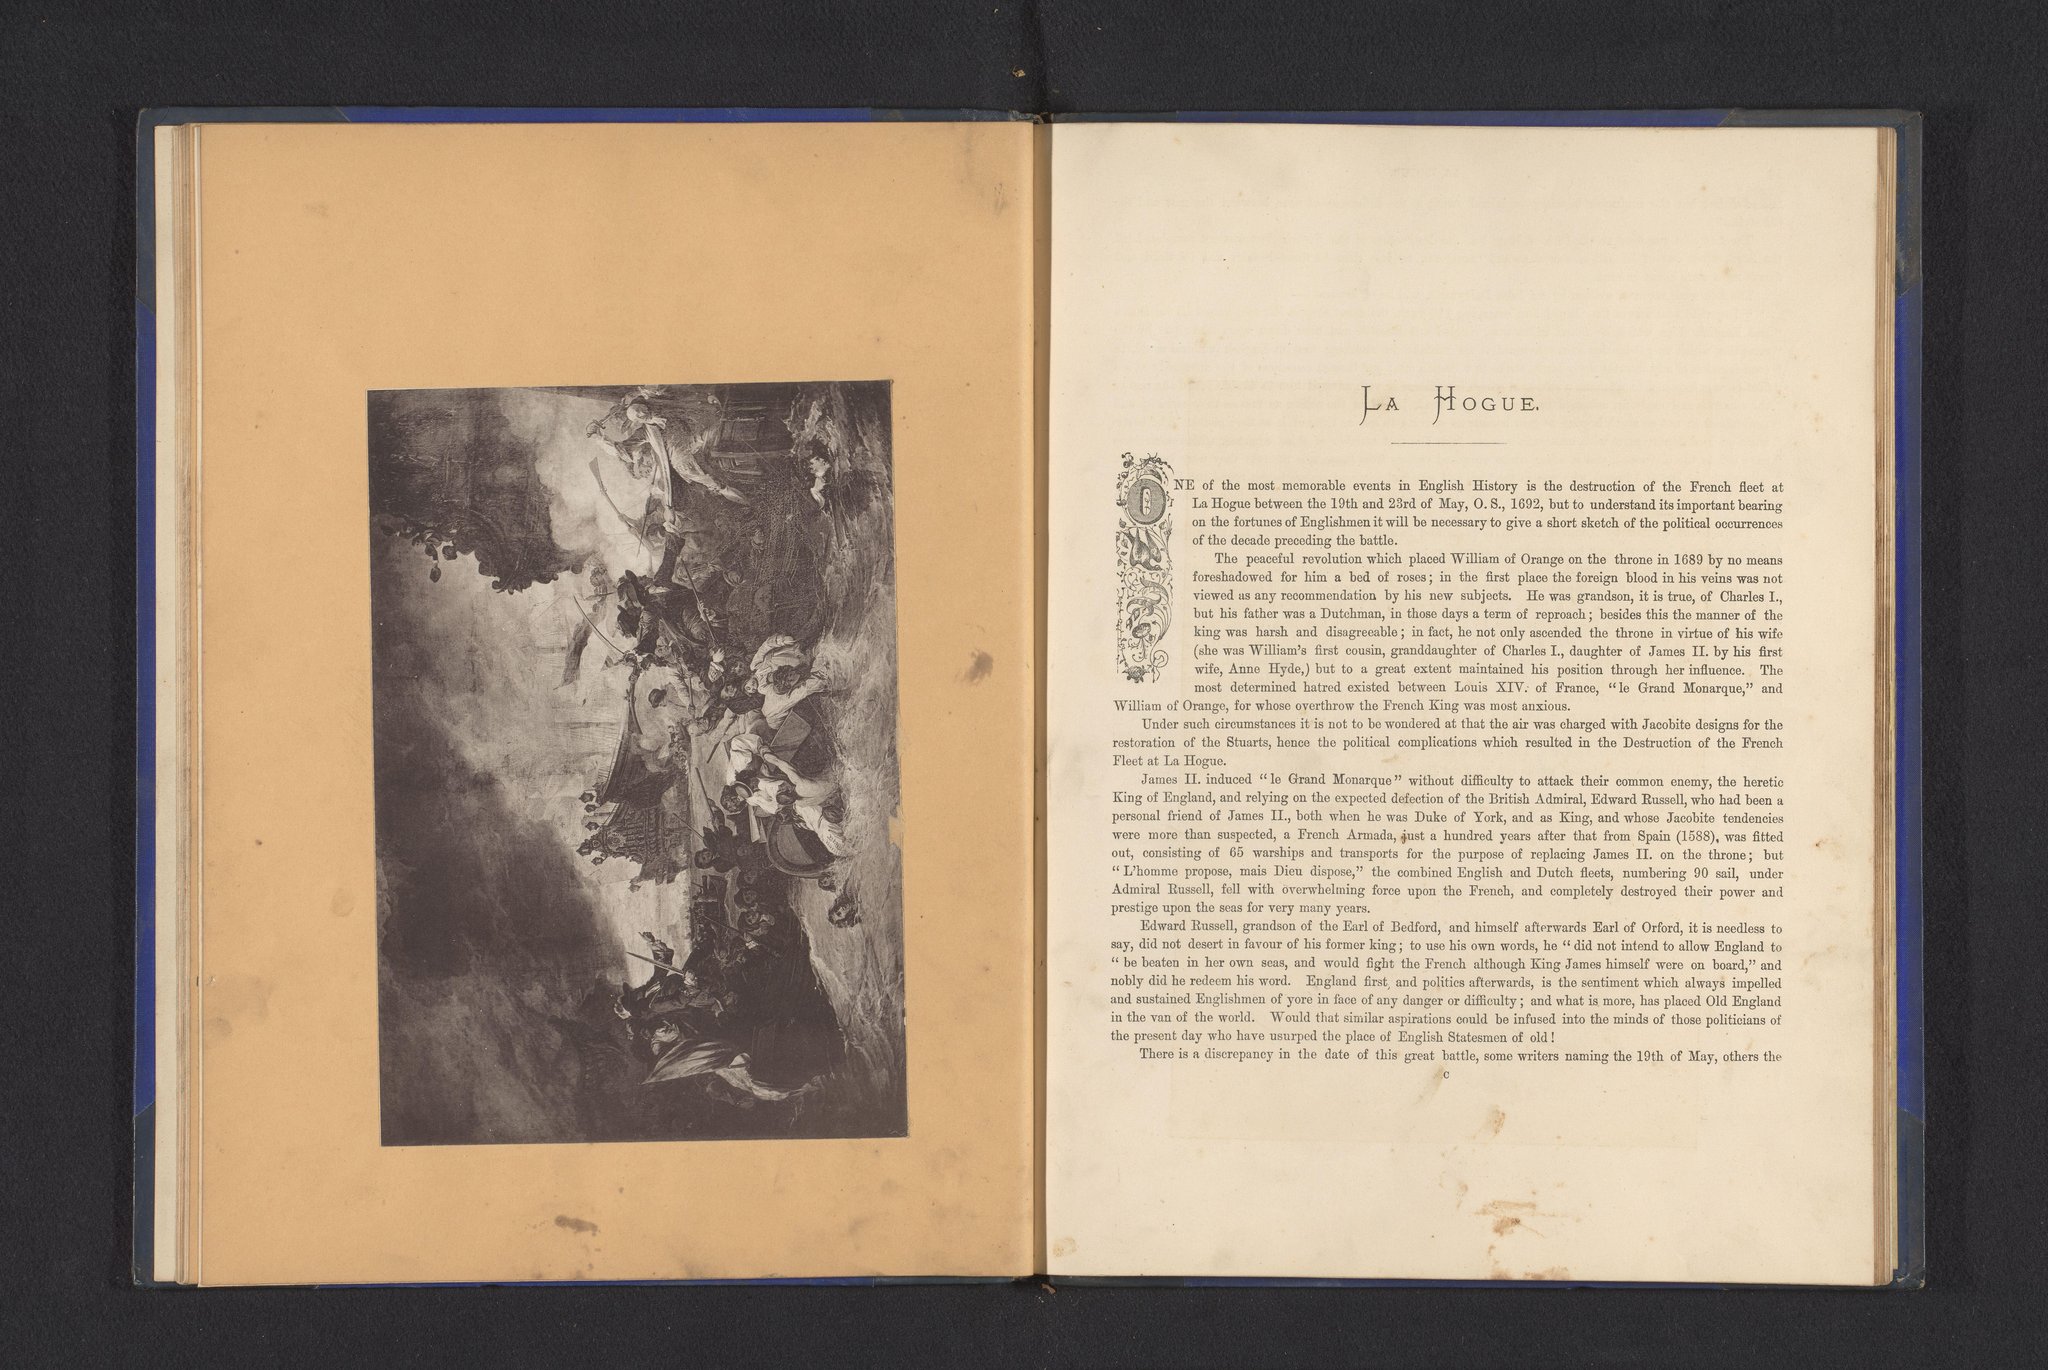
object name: photomechanical print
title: Reproductie van The Battle of La Hogue door William Woollett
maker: Anonymous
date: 1876-1881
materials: paper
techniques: photograph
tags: battle (+ naval force)